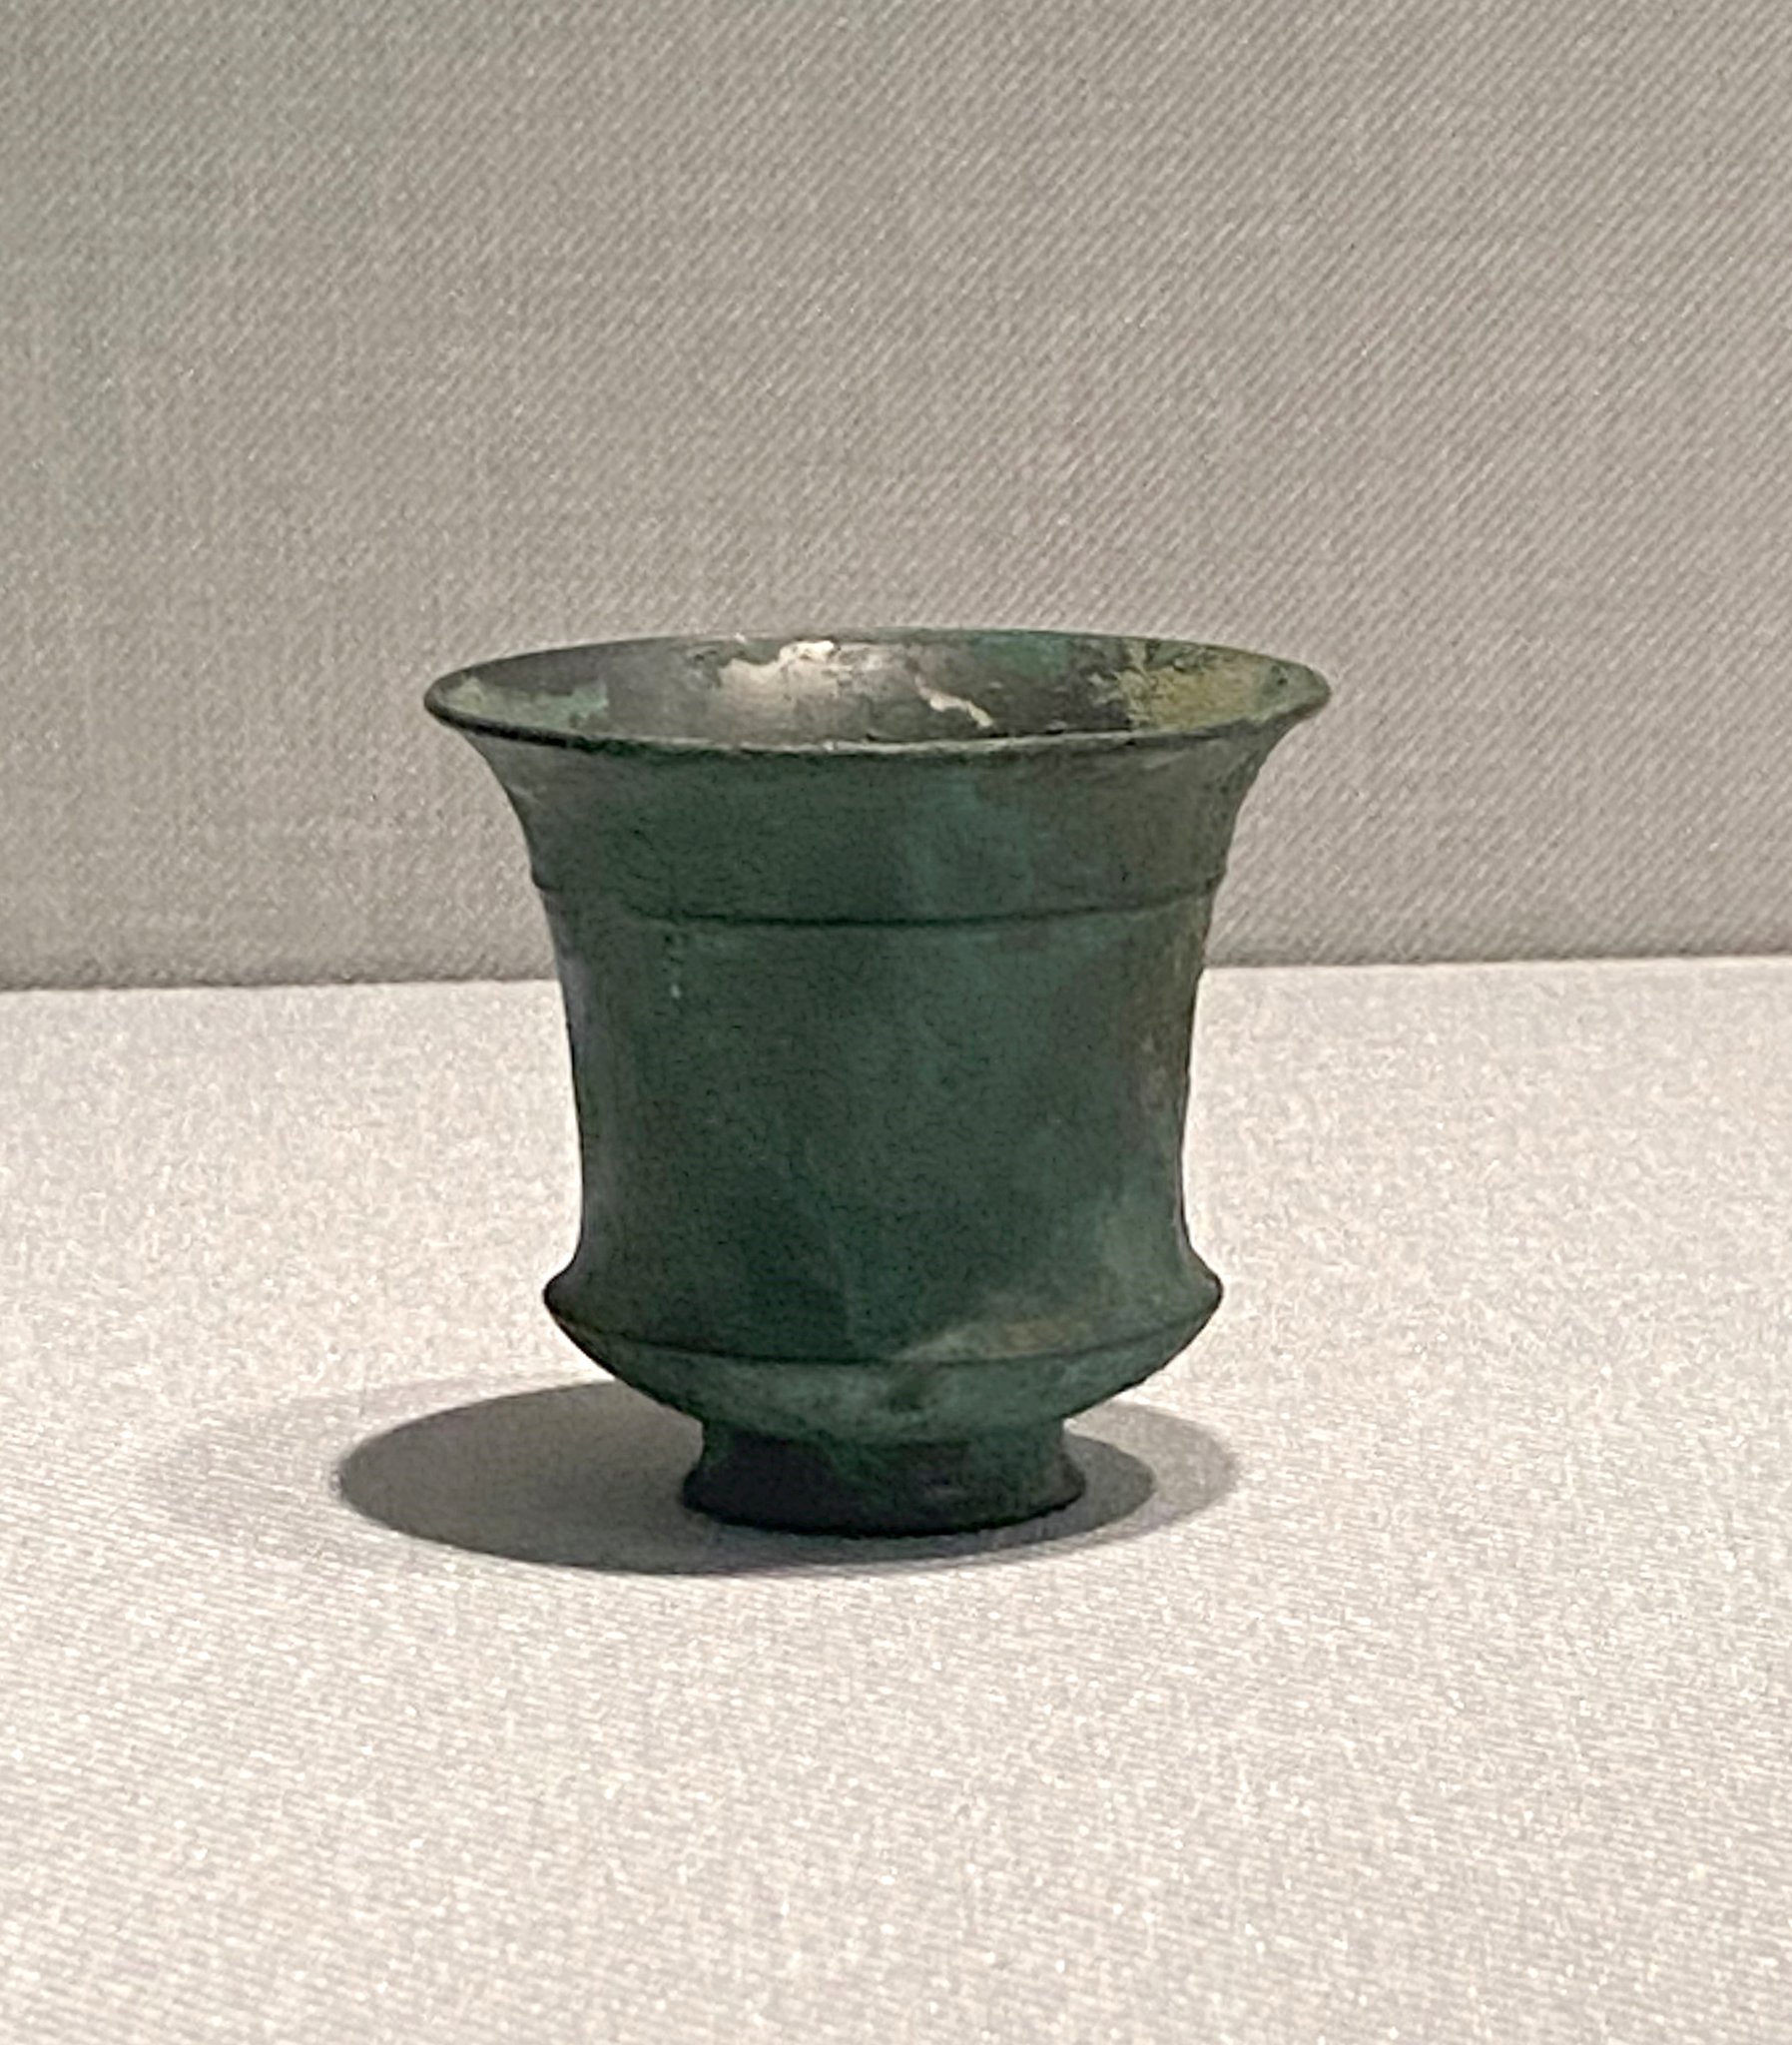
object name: cup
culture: korean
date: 918-1392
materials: bronze